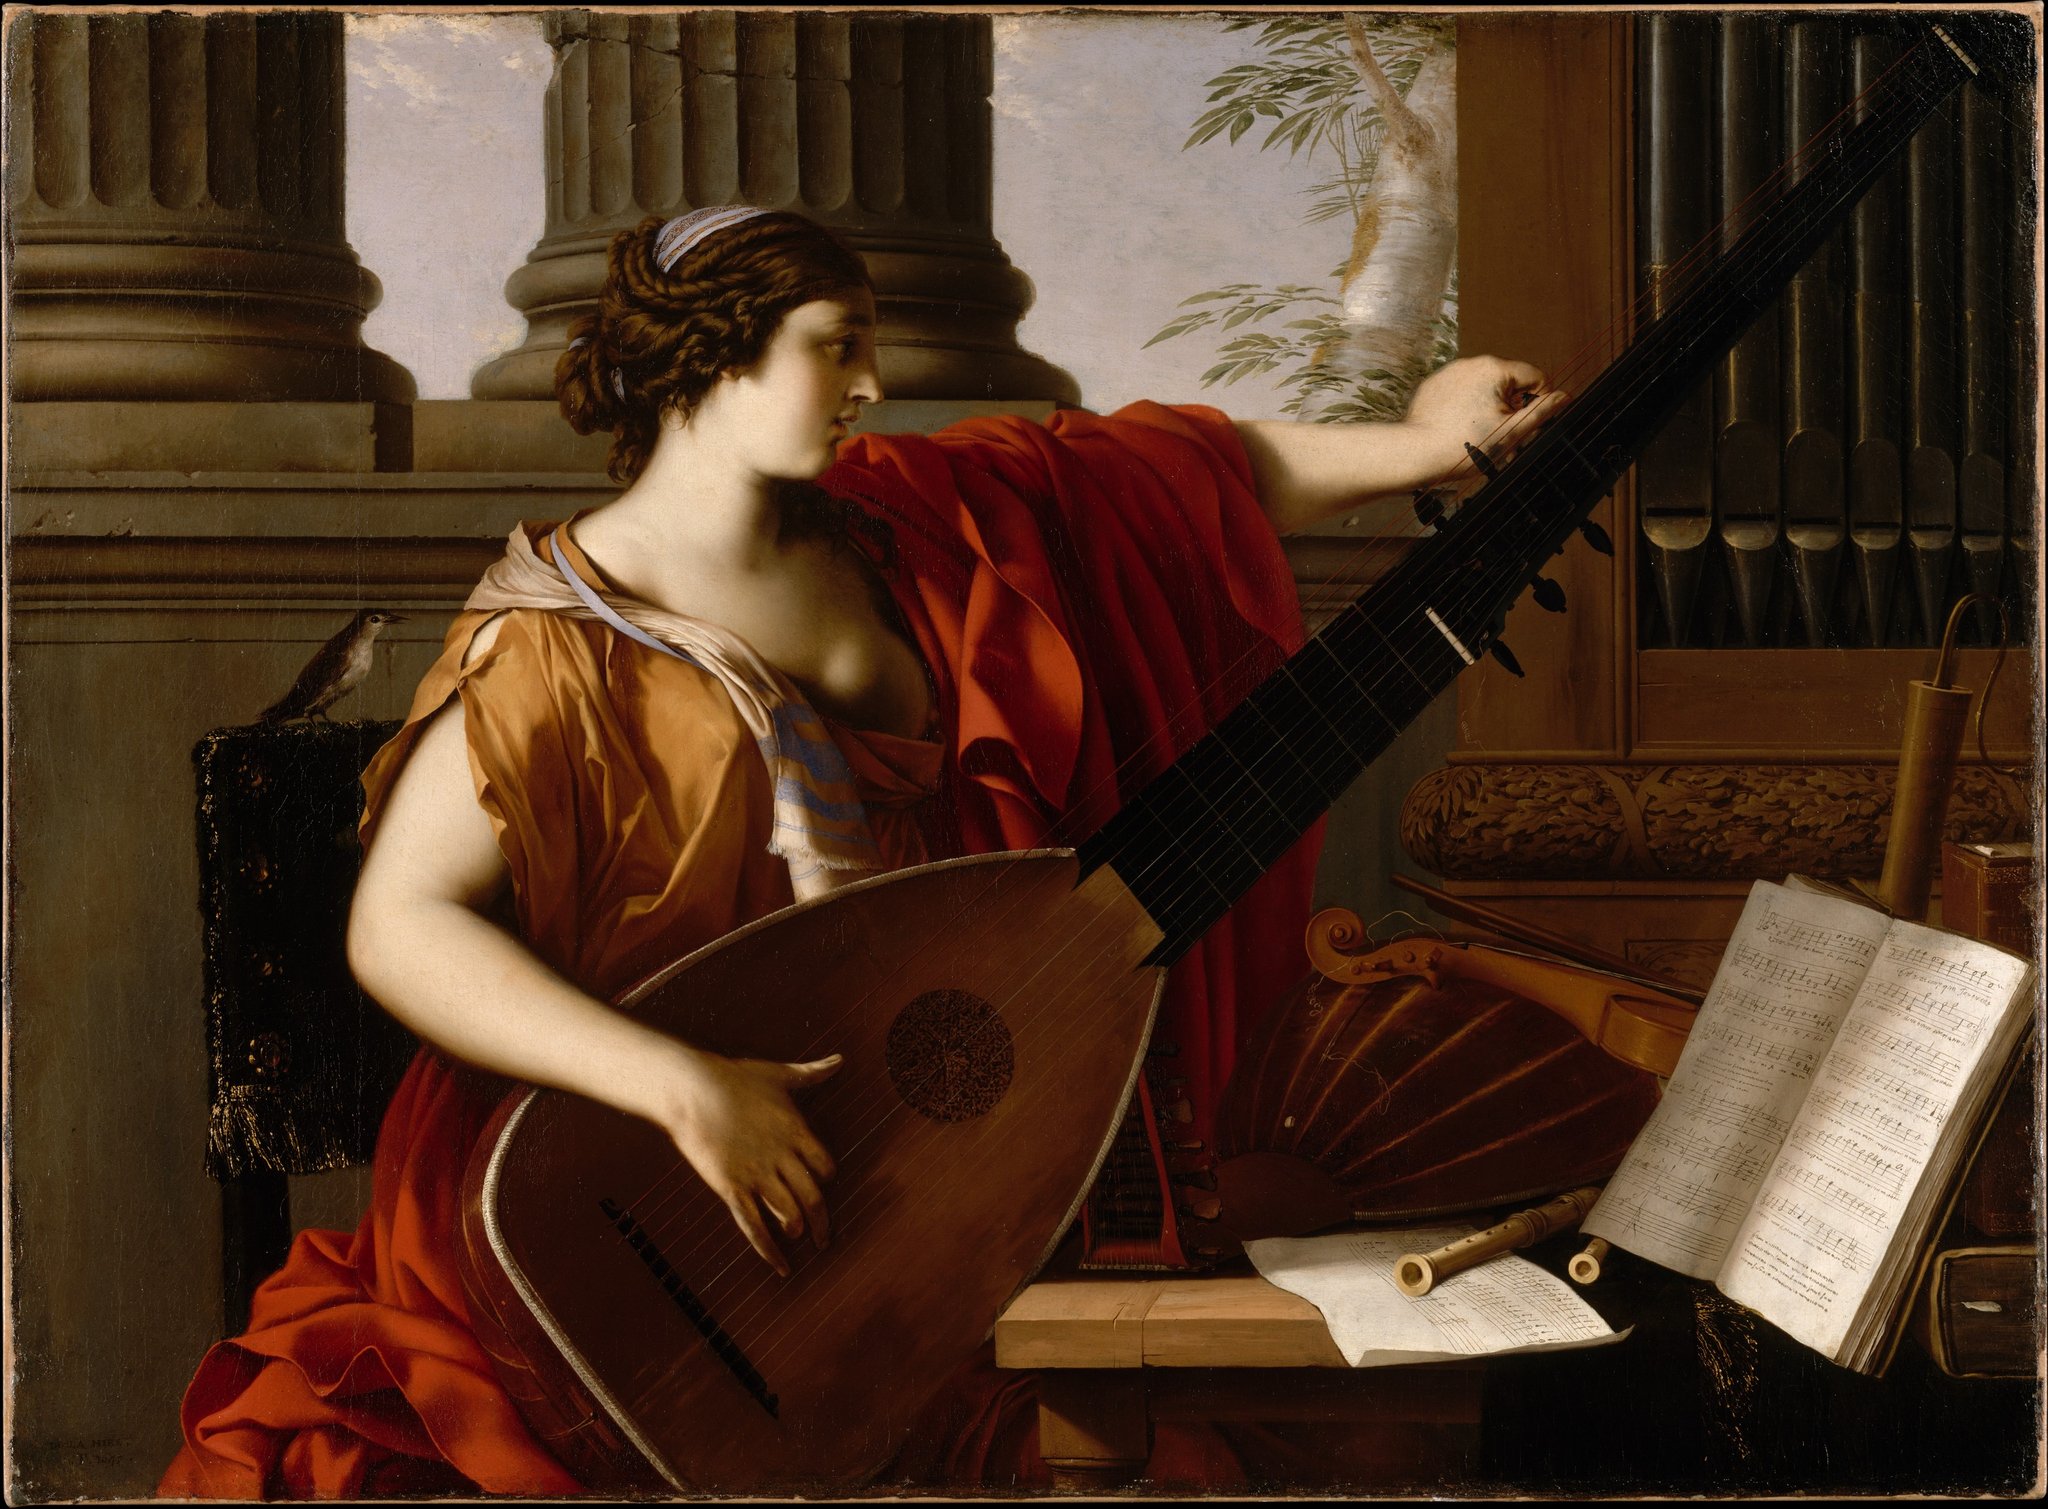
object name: painting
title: Allegory of Music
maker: laurent de la hyre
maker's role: artist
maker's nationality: french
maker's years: 1606-1656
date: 1649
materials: canvas, oil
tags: birds,women,music,lutes,violins,allegory